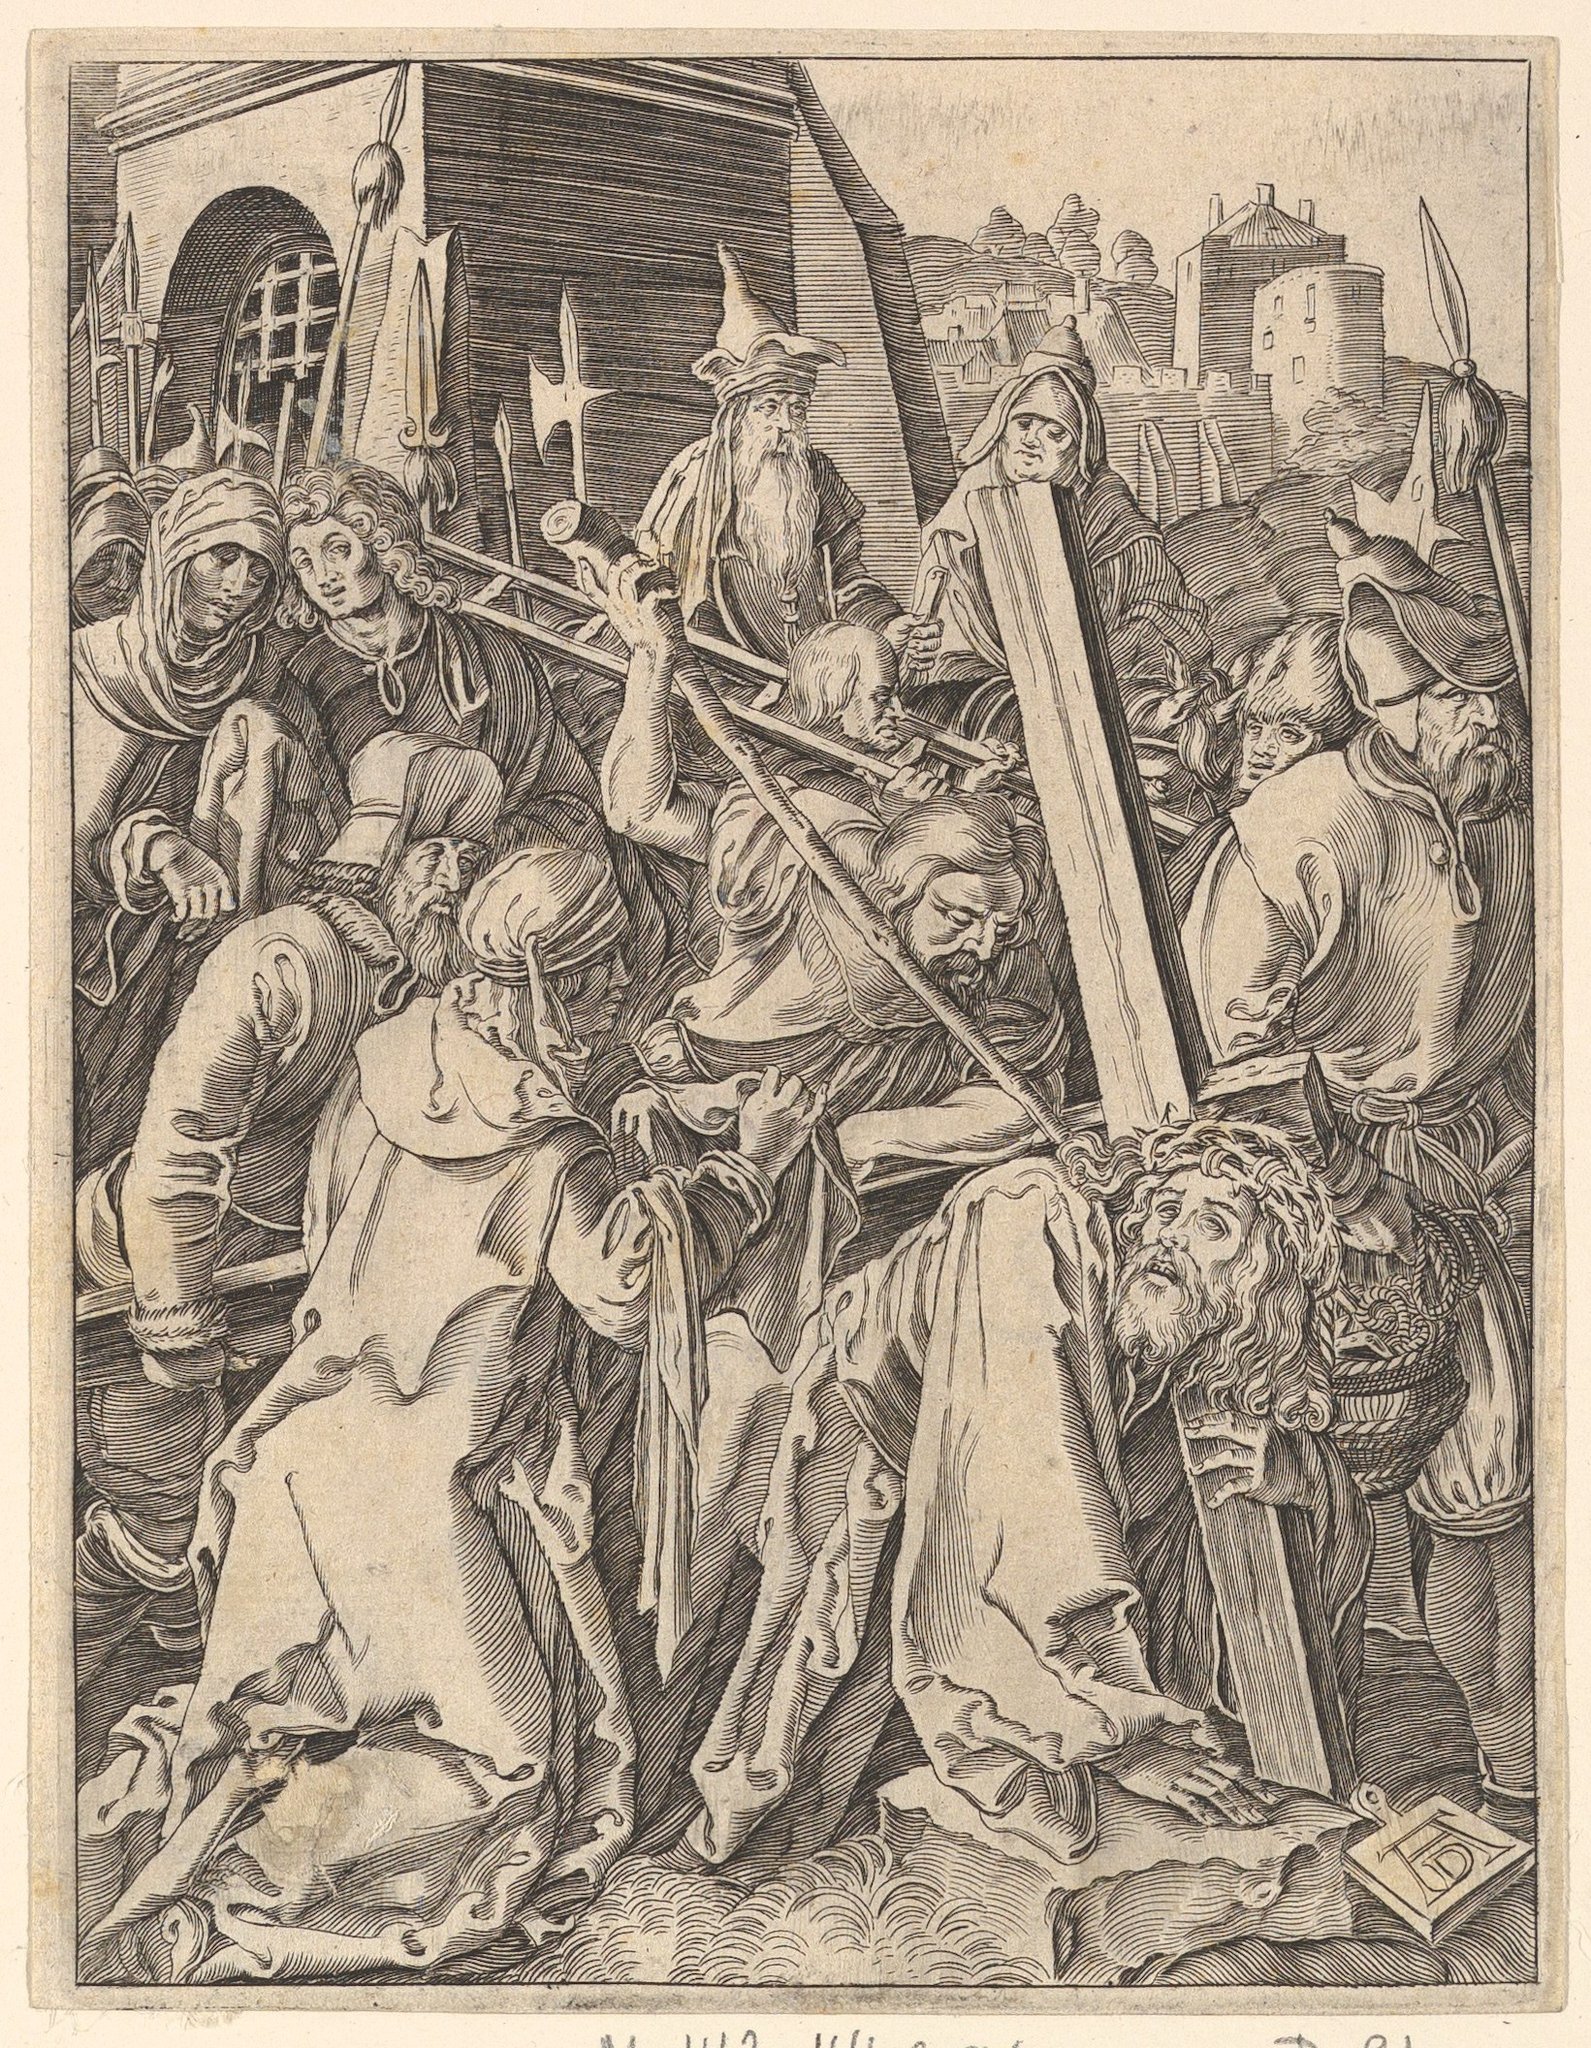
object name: print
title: Engraved copies of The Little Passion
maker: albrecht dürer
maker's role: artist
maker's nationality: german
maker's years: 1471-1528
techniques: engraving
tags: weapons,suffering,men,christ,cross